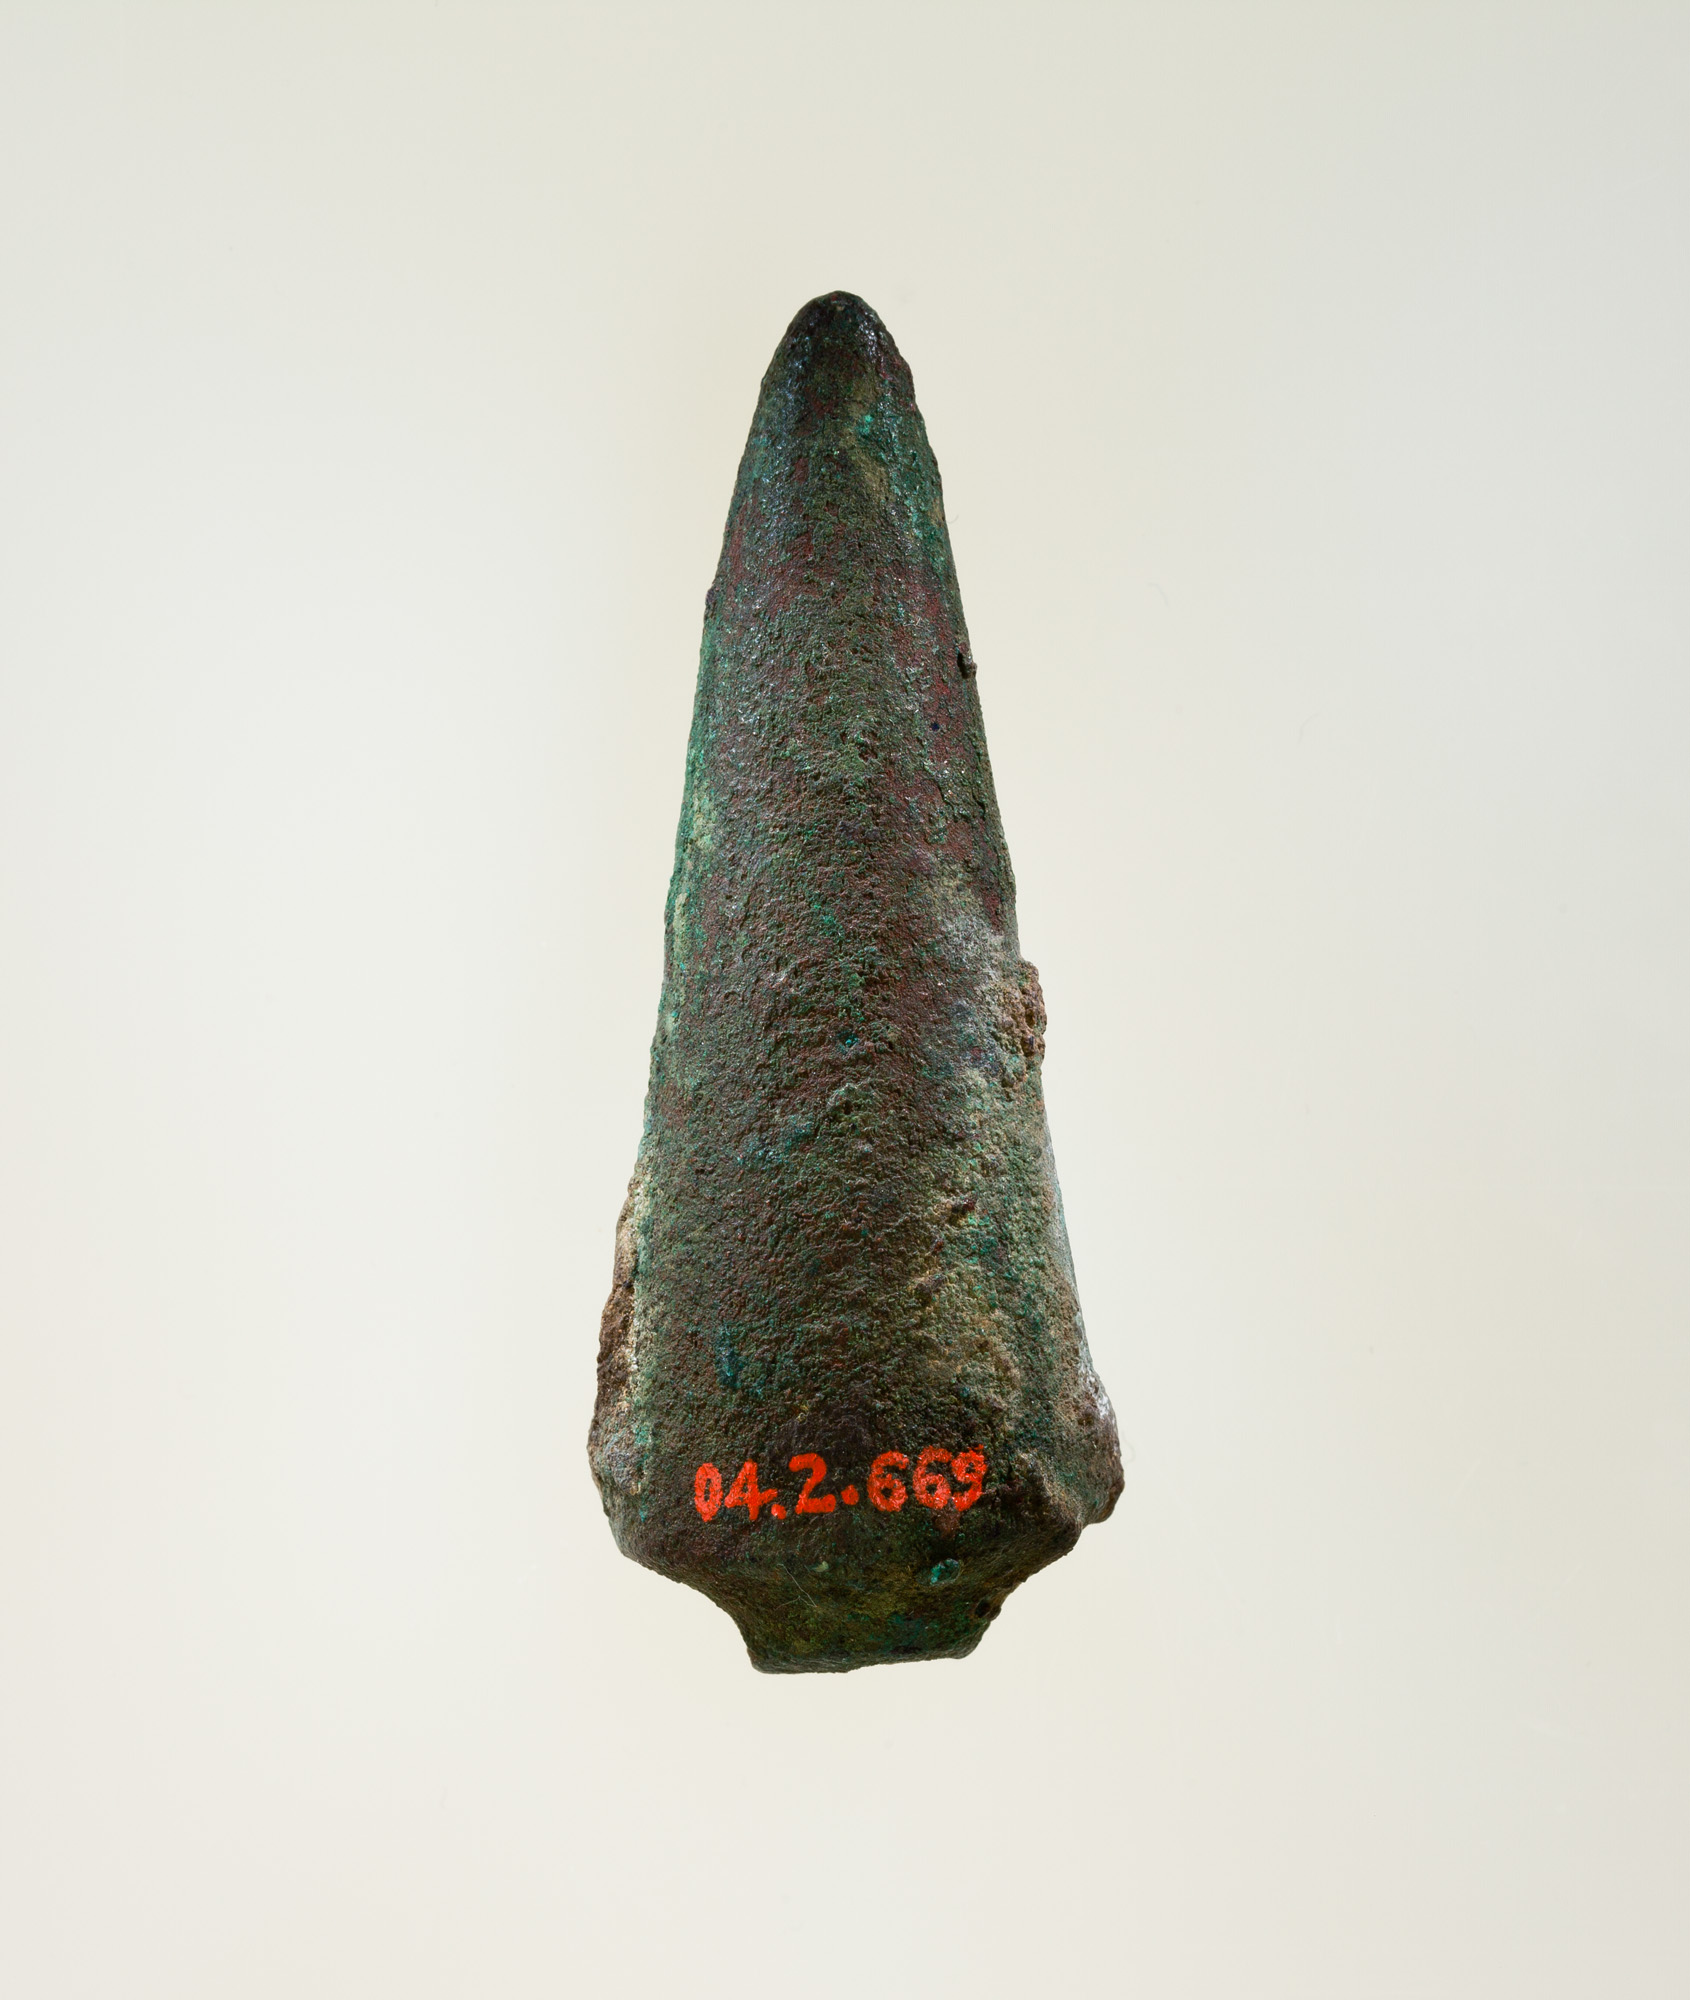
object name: ornament, lotus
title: Lotus ornament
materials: copper alloy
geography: egypt